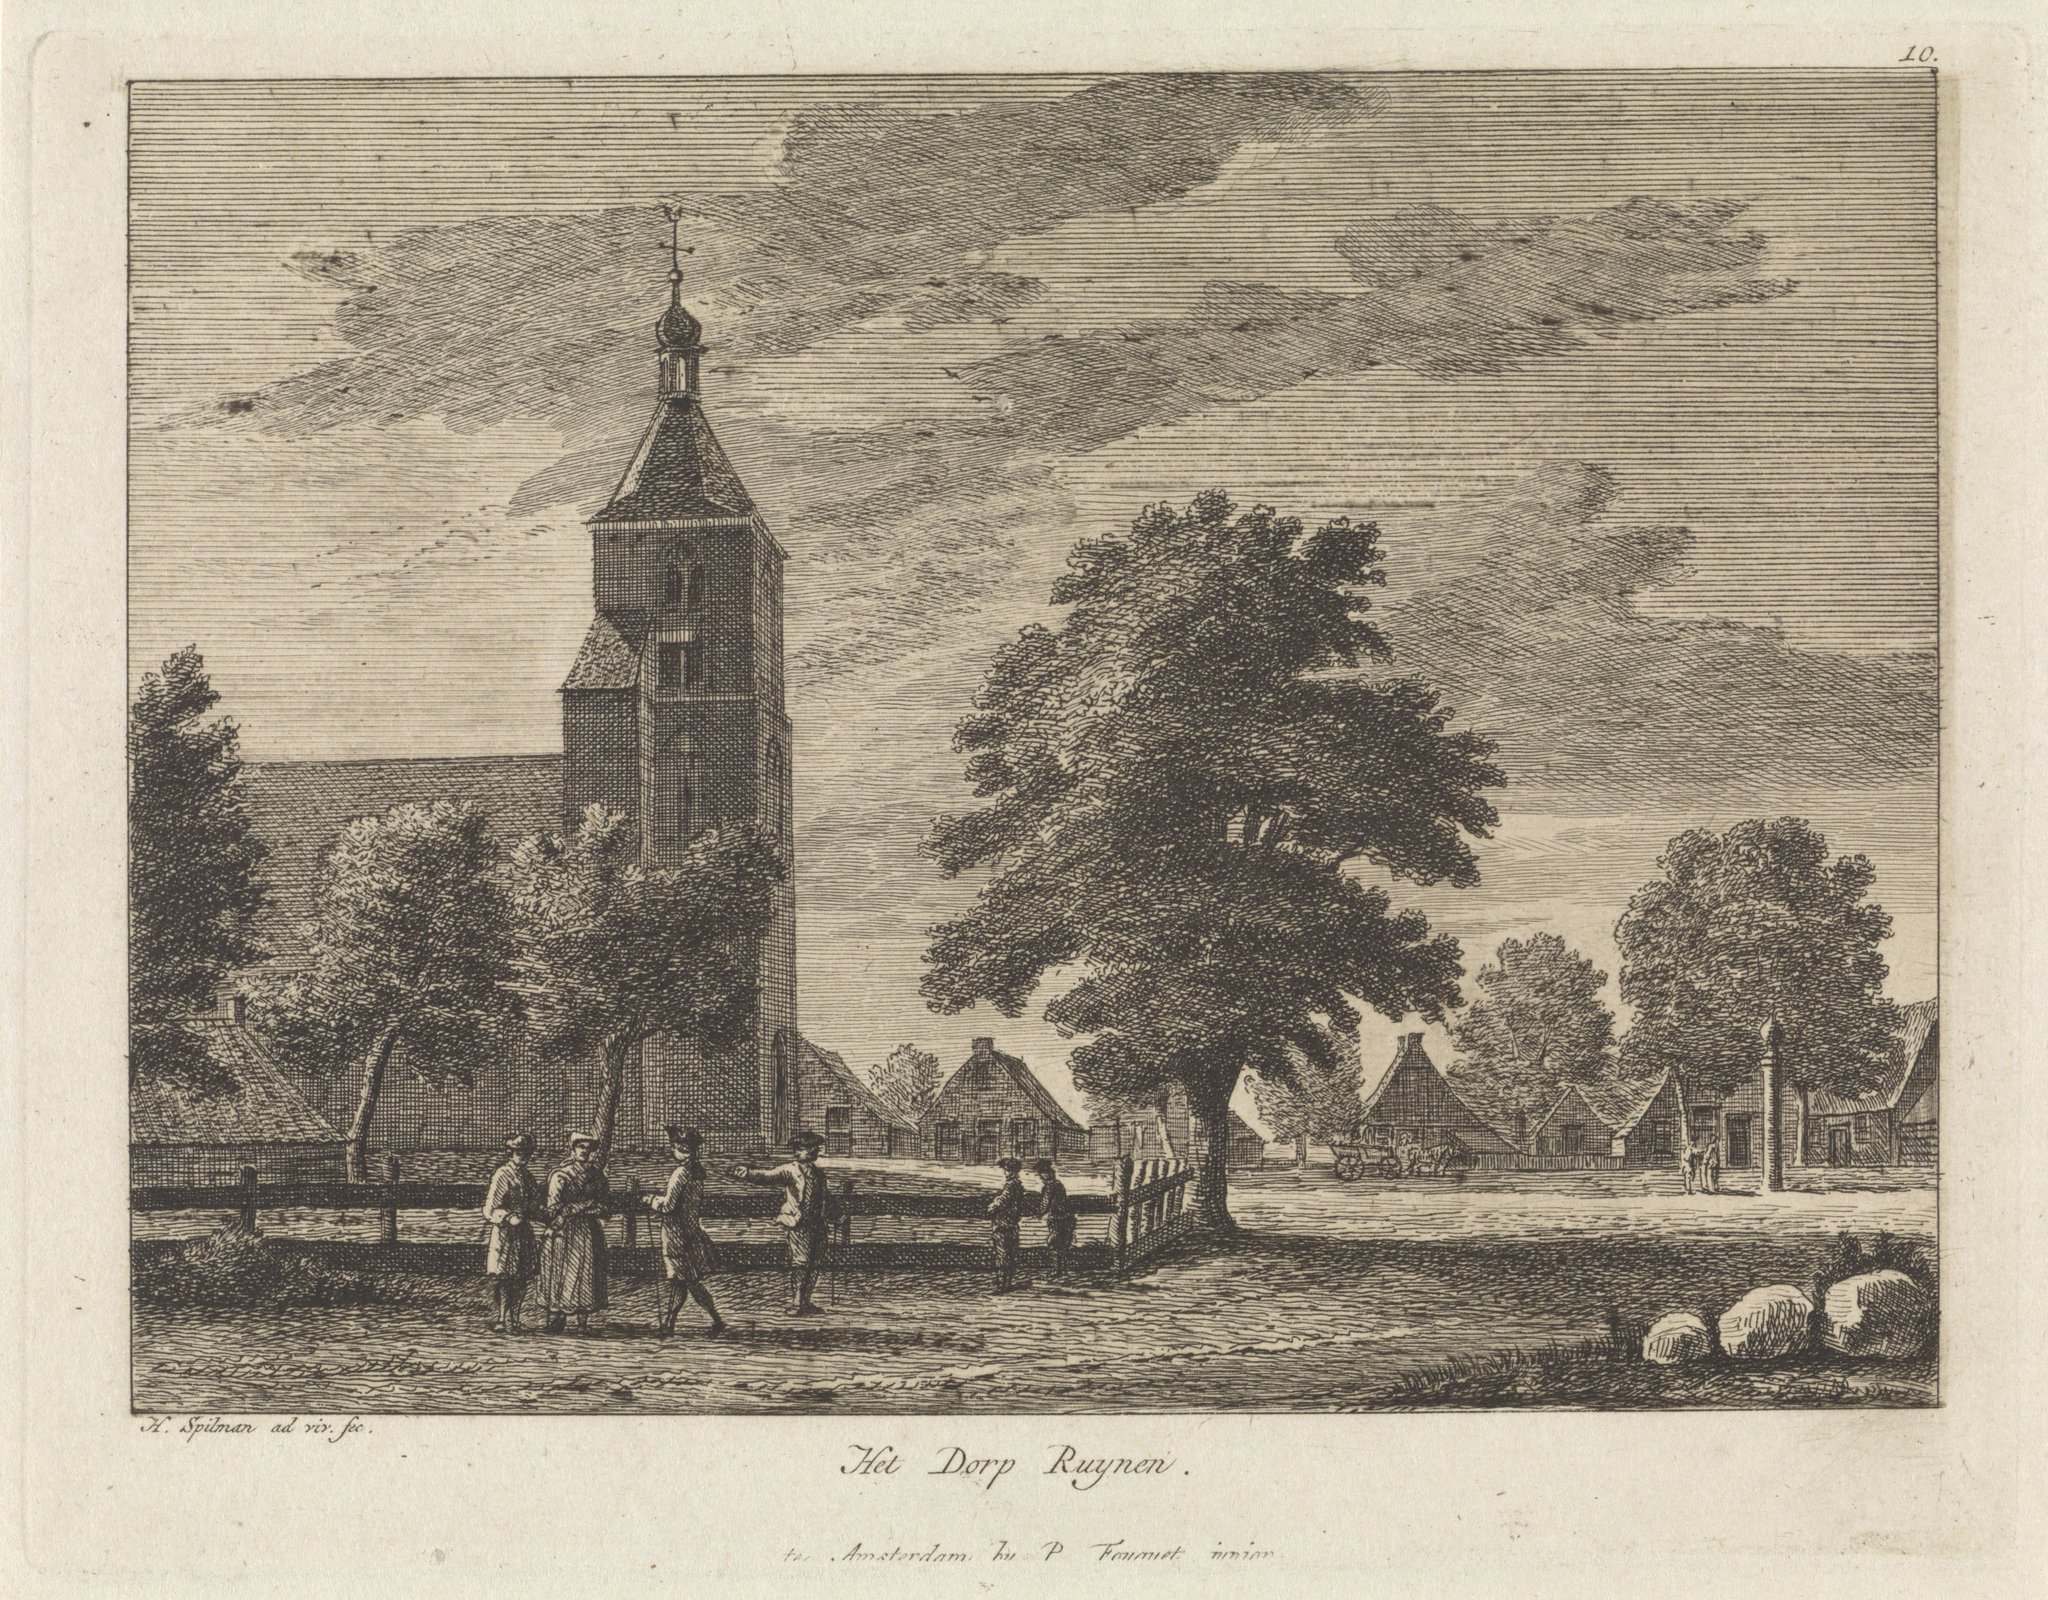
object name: print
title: Het dorp Ruynen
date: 1760-1796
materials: paper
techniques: etching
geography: amsterdam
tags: church (exterior), village square, place (+ city(-scape) with figures, staffage)